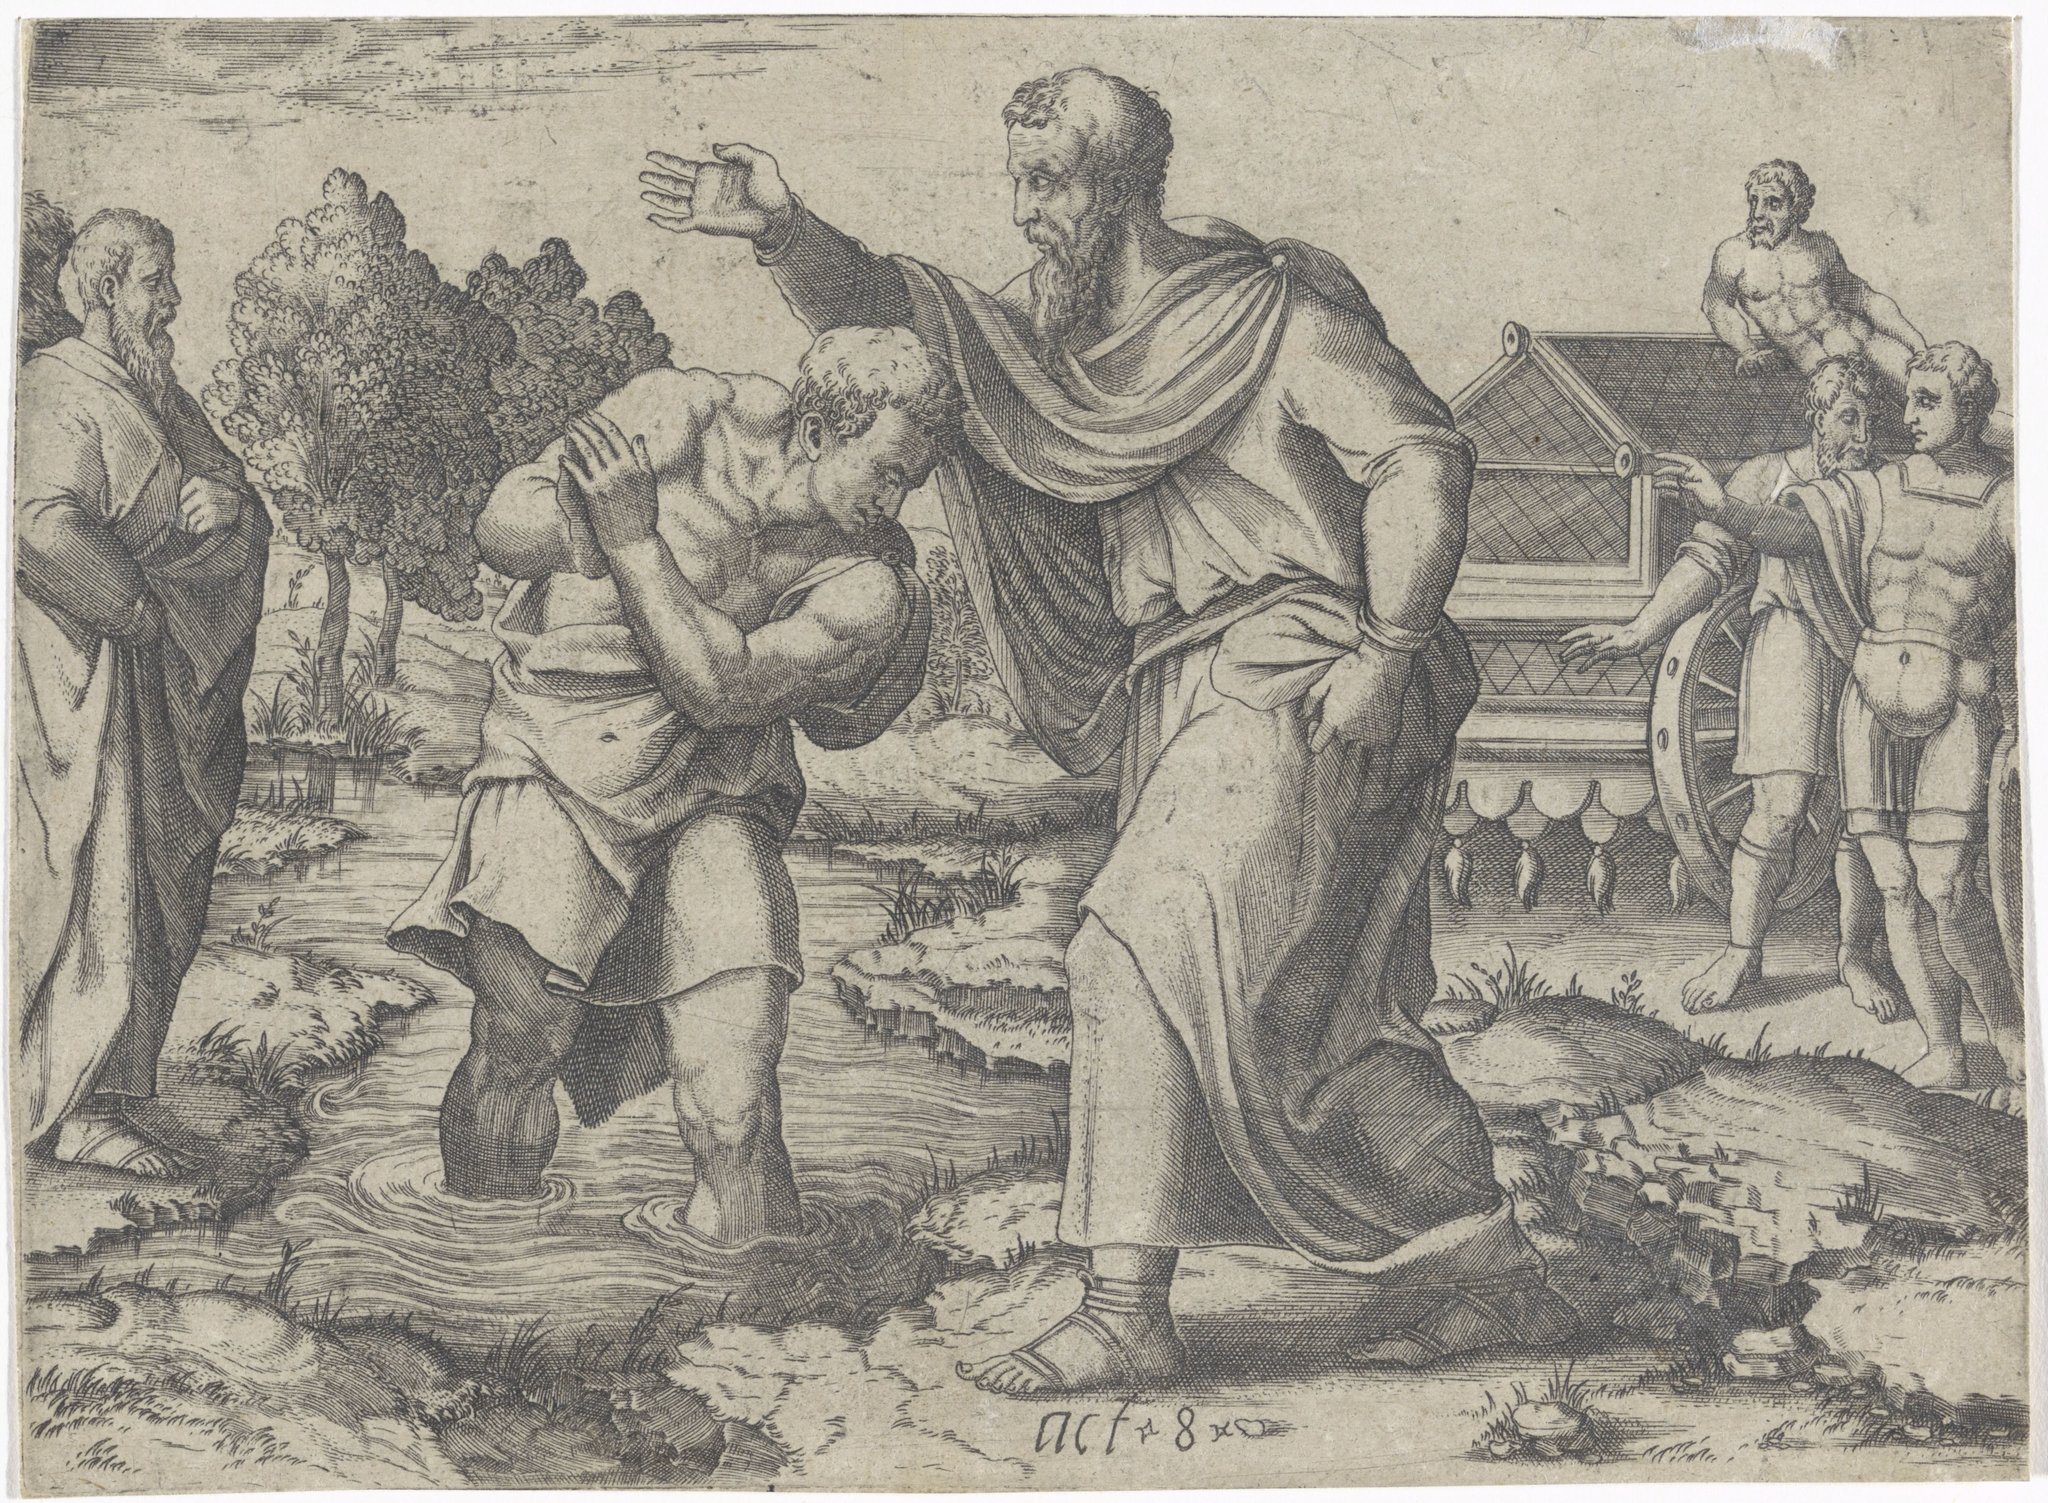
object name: print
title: Scènes uit het boek Handelingen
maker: lambertus suavius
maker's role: print maker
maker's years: 1514-1564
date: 1520-1567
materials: paper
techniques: engraving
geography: southern netherlands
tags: philip baptizes the eunuch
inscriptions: collector's mark: Lugt 240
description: De apostel Filippus doopt de kamerling uit Ethiopië. Rechts de koets van de kamerling en drie mannen. Naar het Bijbelverhaal in Hand. 8: 26-40